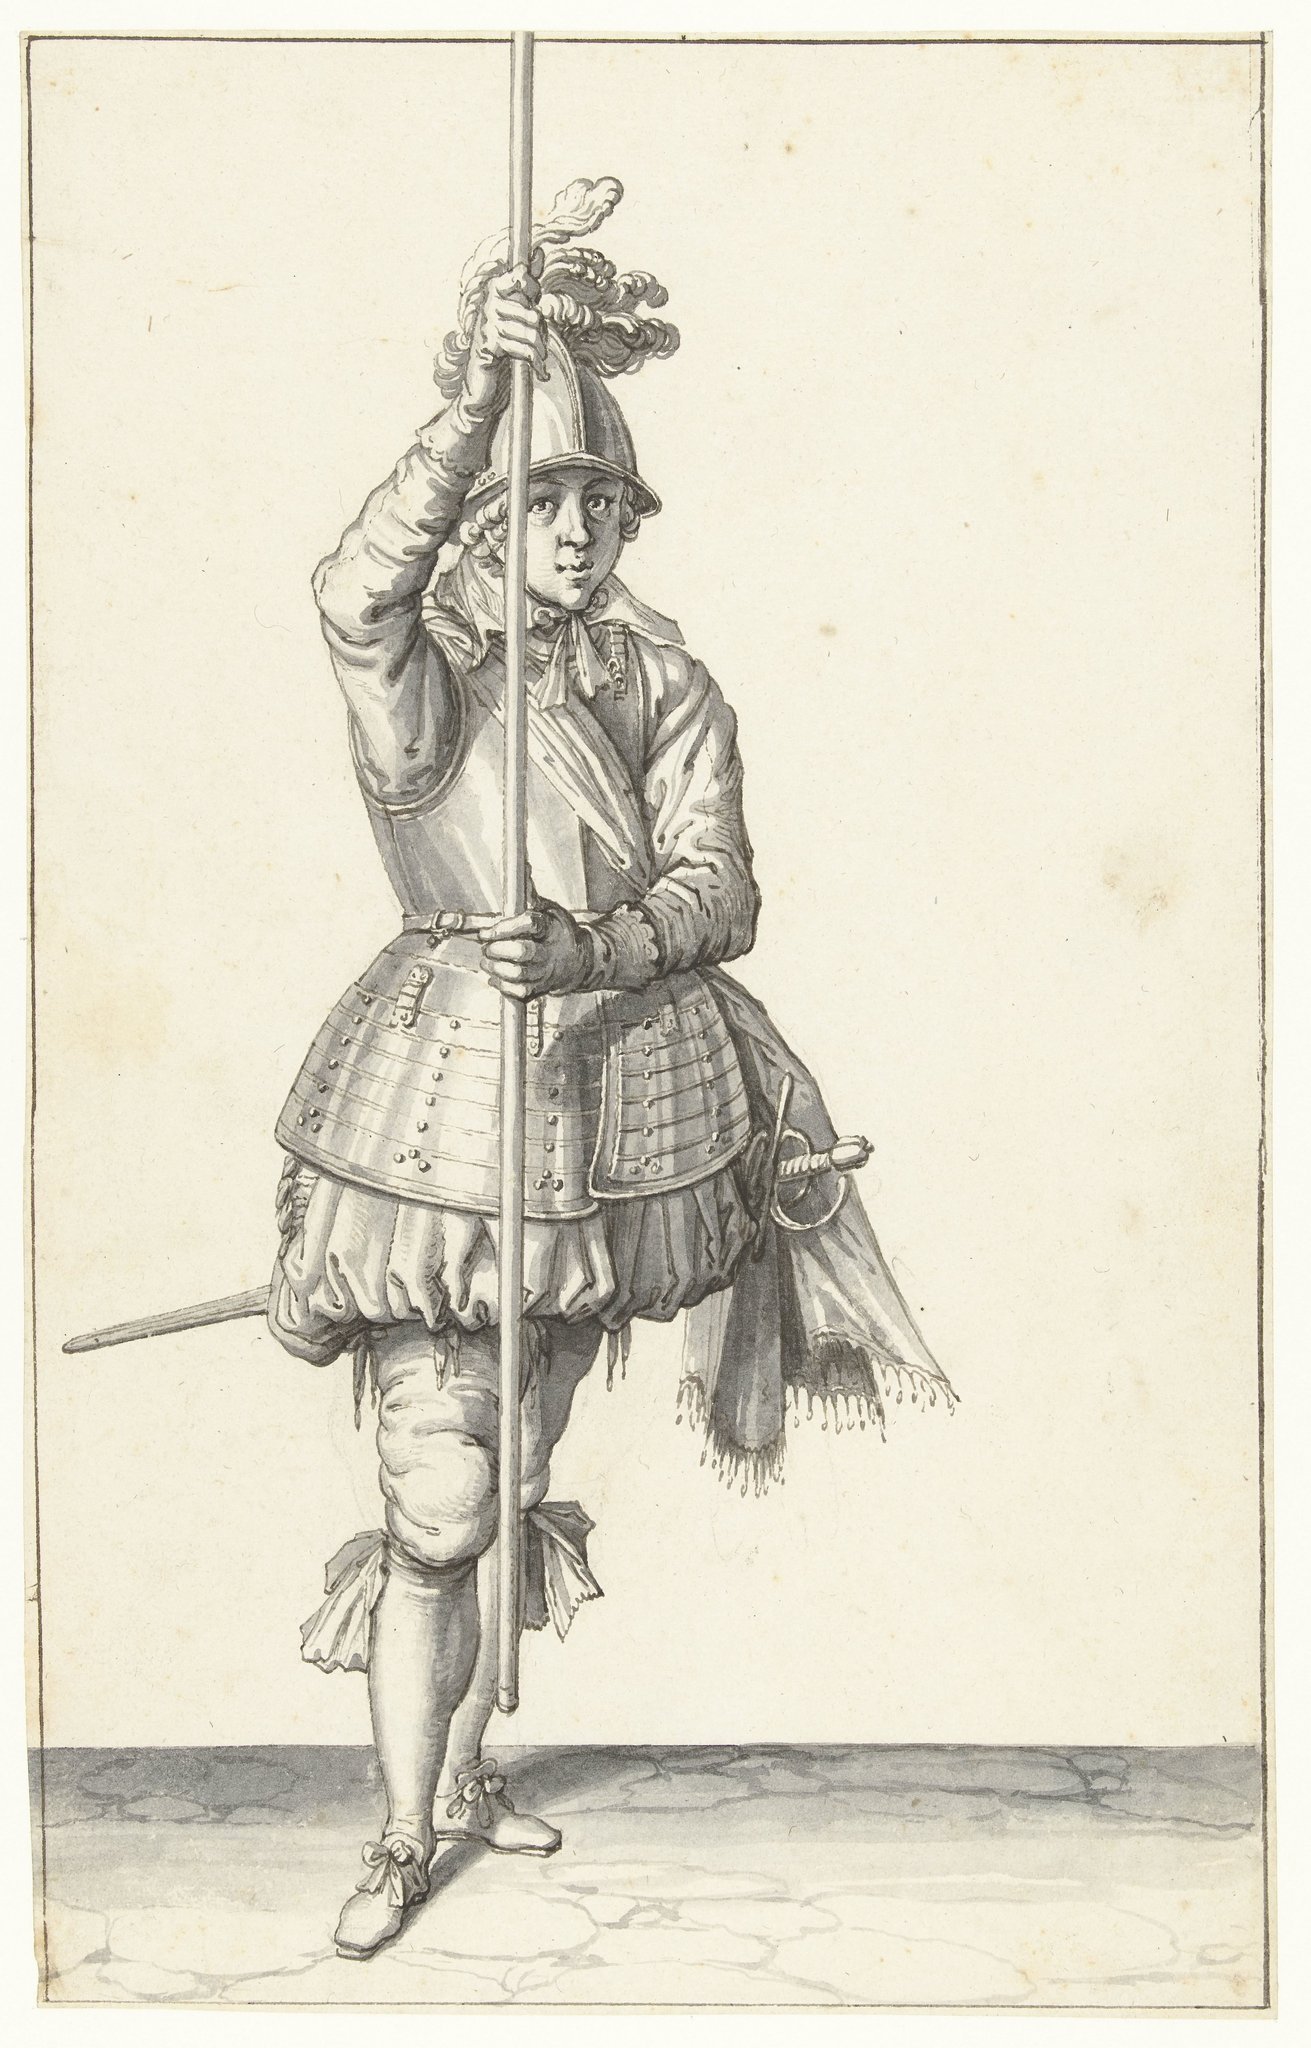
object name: design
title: Wapenhandelinghe van Spiessen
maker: jacques de gheyn (ii)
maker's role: painter, print maker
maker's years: 1565-1629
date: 1596-1606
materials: ink, paper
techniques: brush, pen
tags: handling of weapons ~ military training